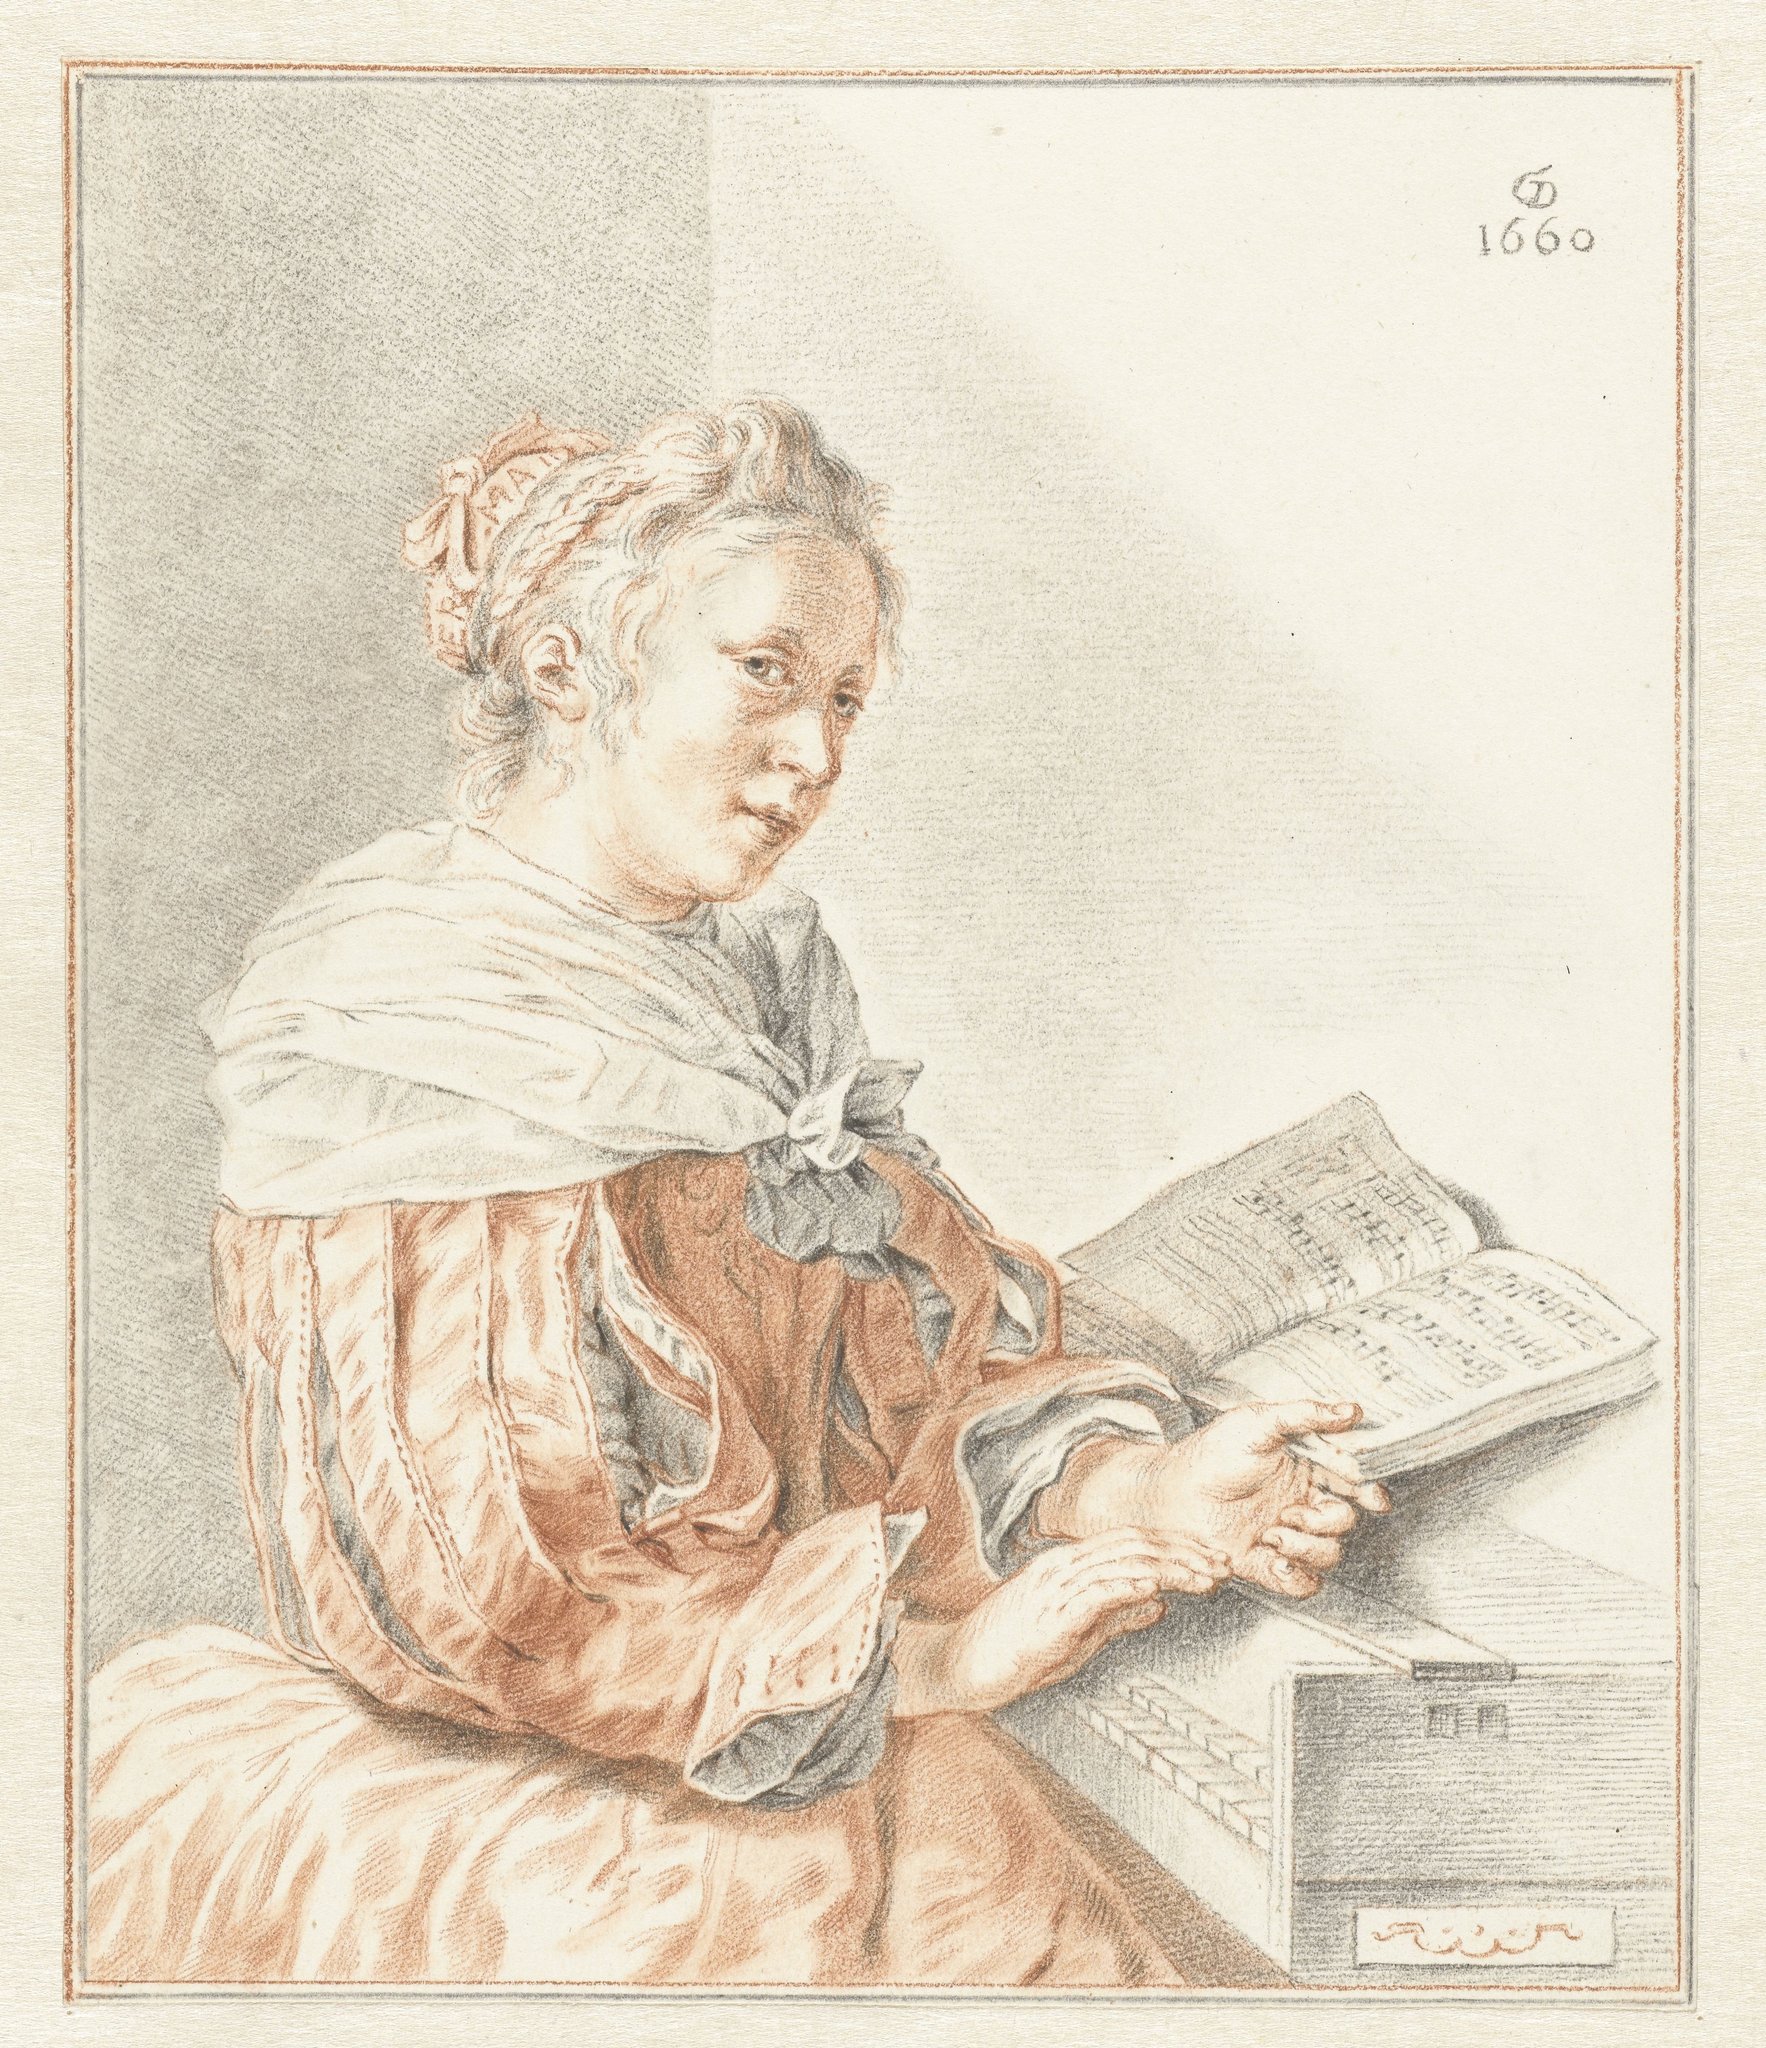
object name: drawing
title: Dame bij spinet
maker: abraham delfos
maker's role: draughtsman, painter, print maker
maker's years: 1731-1820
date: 1798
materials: chalk, paper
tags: one person playing keyboard instrument, spinet, virginal